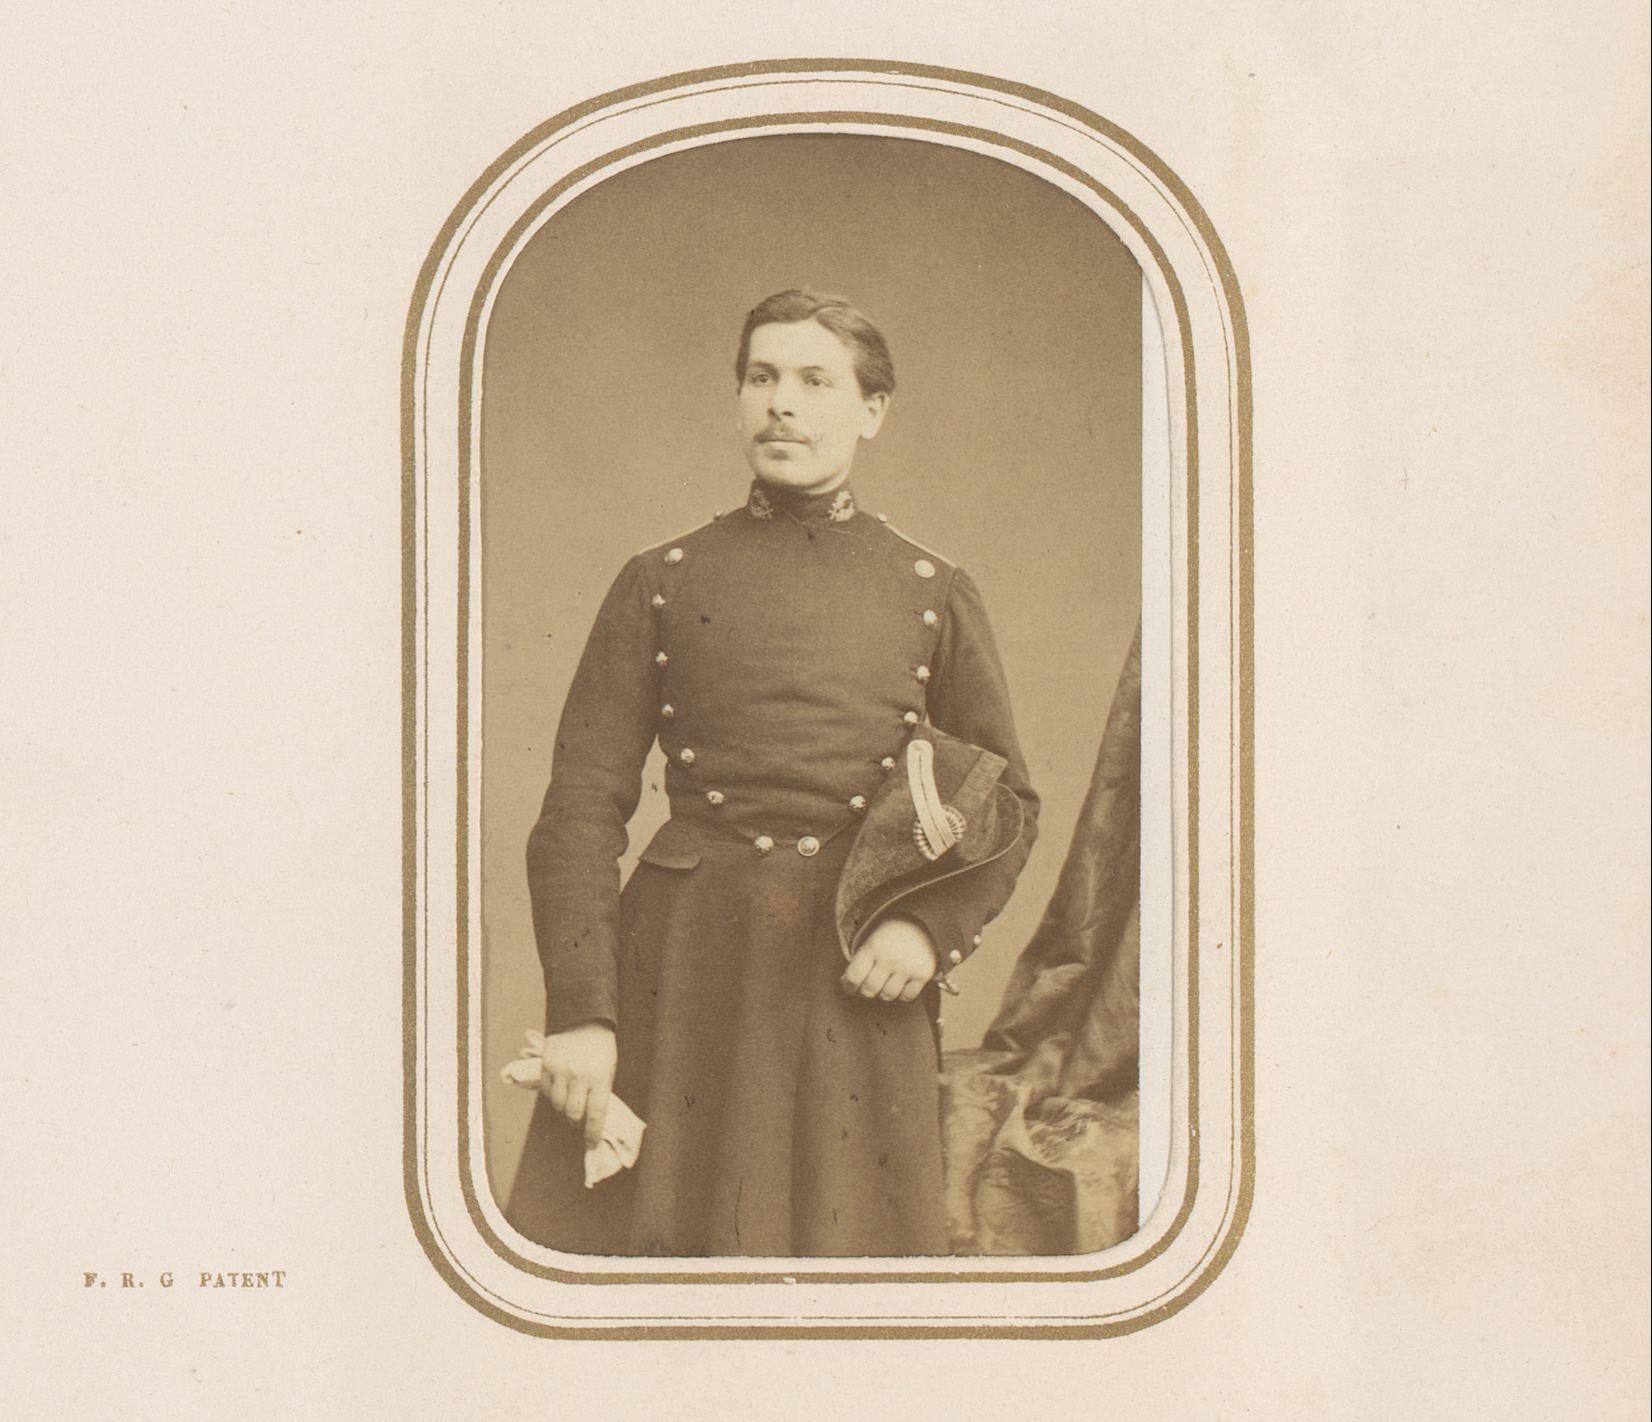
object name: carte de visite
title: Portret van een man in uniform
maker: eugène hallier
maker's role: fotograaf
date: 1850-1890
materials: cardboard, photographic support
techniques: albumen print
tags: adult man, historical persons, (military) uniforms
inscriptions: inscription: ‘Photographie Universelle/ 17, Rue de Crammont/ Paris’